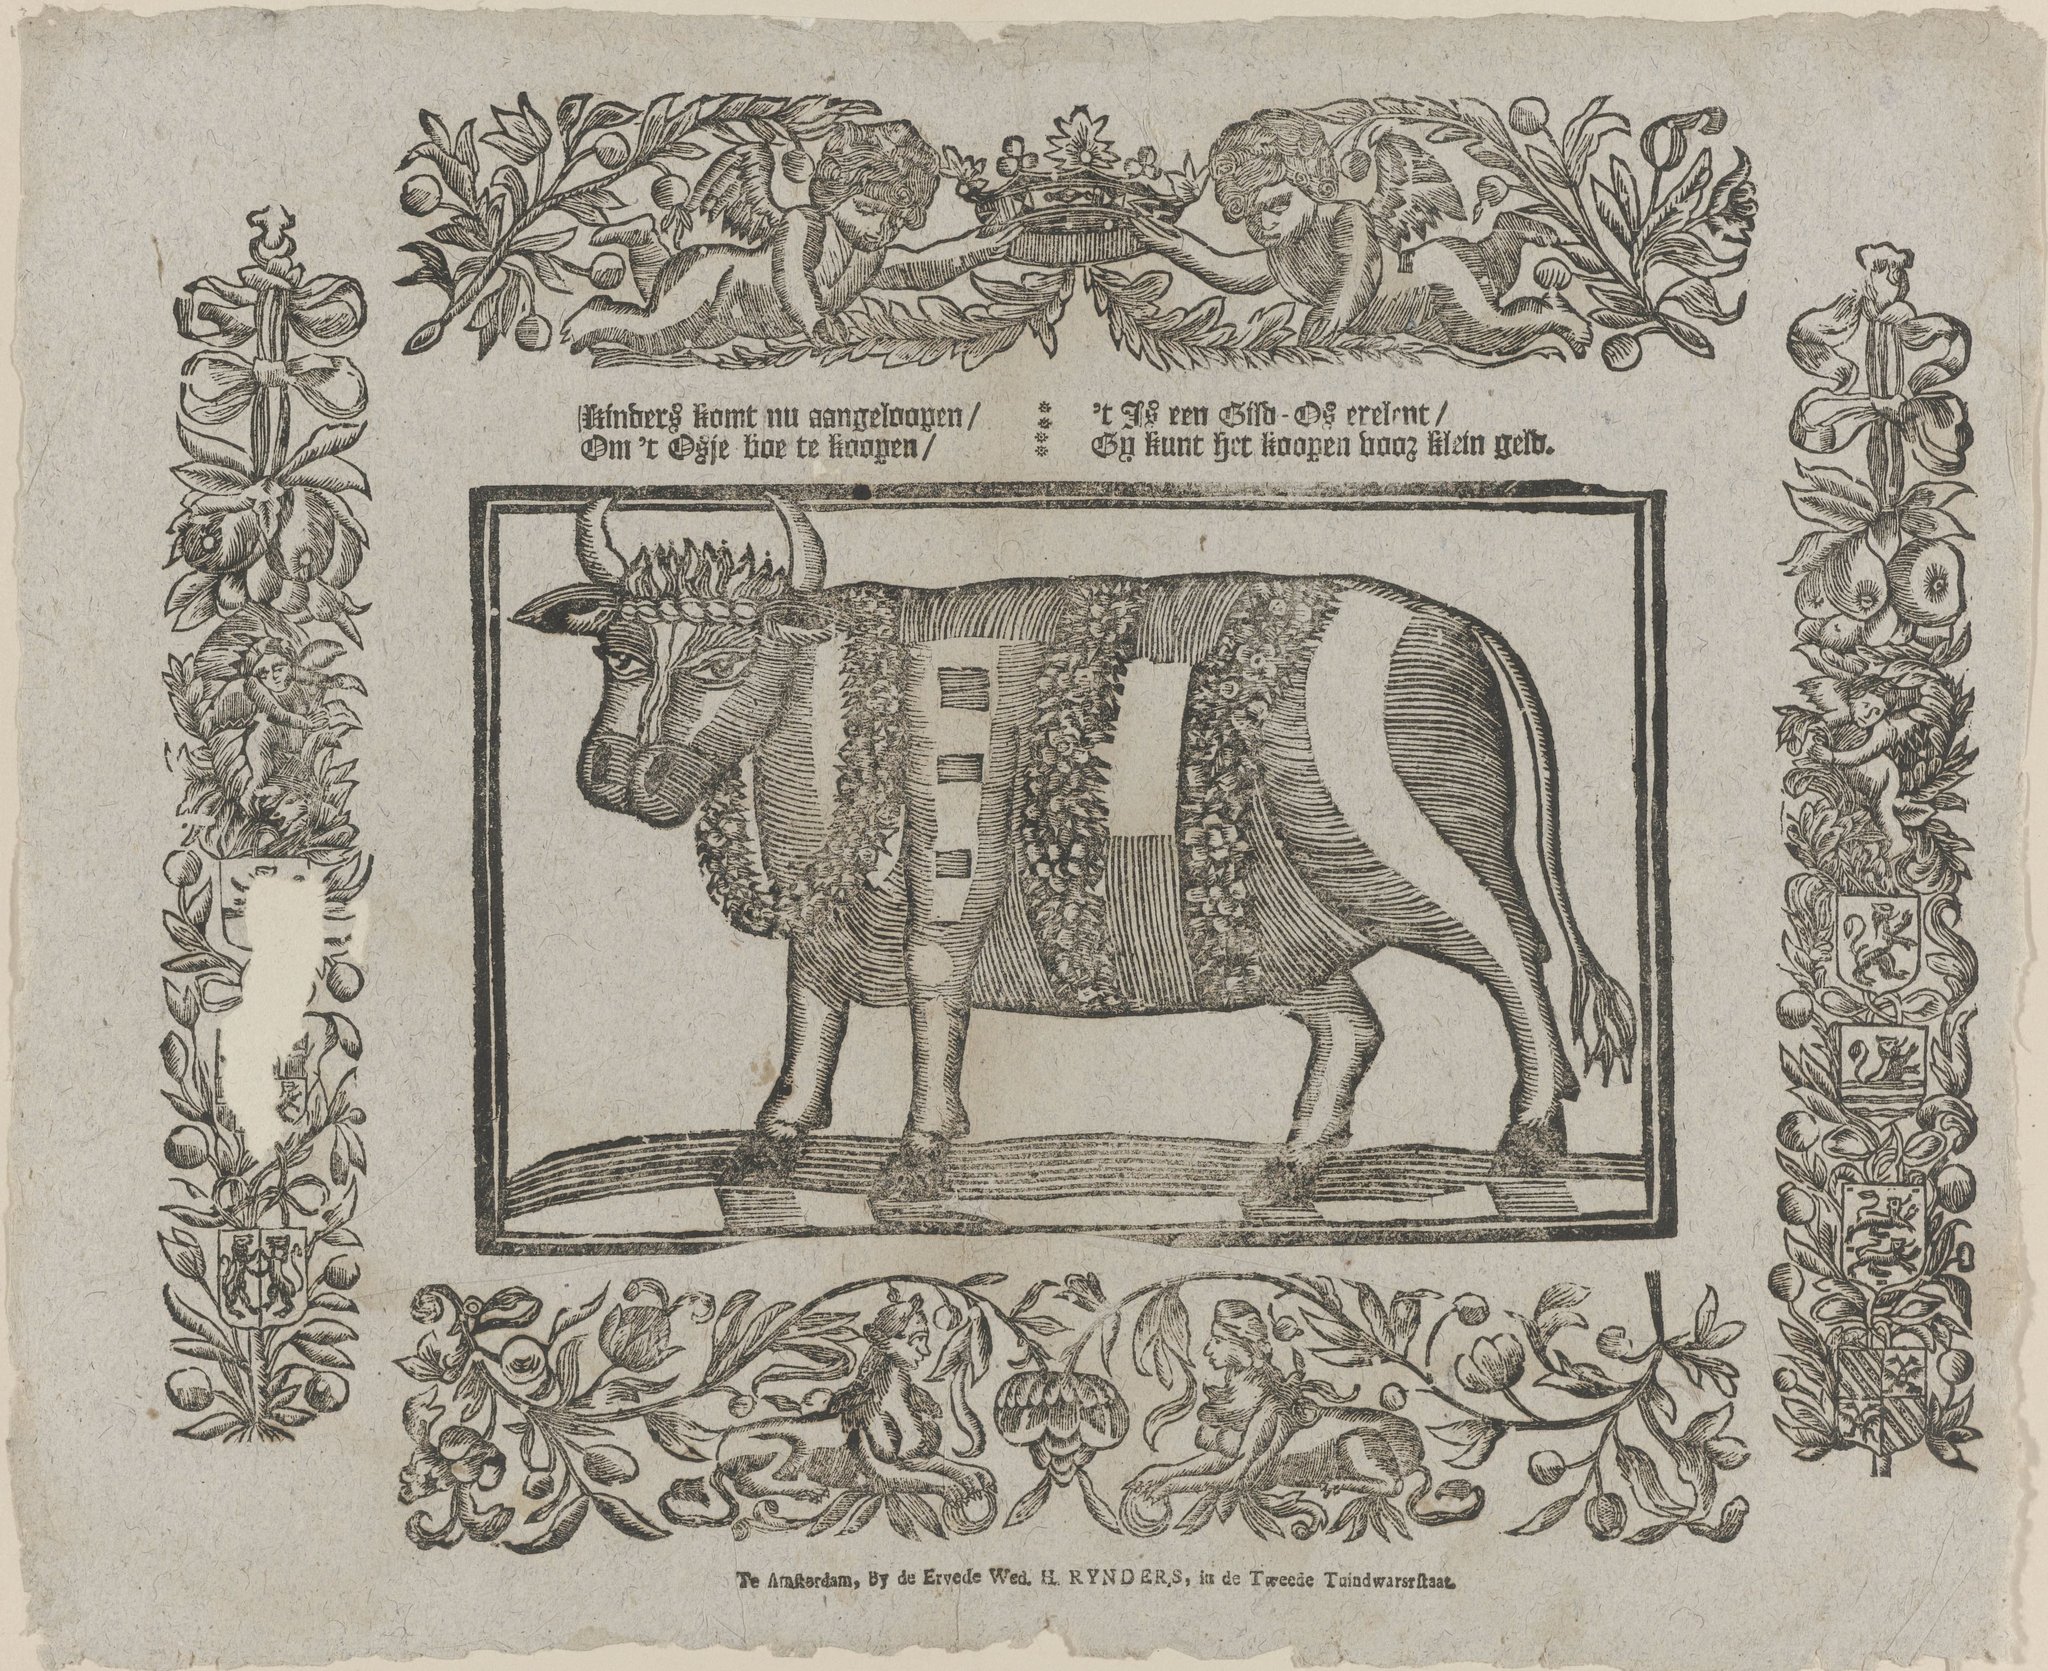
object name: print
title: Kinders komt nu aangeloopen / Om 't osje boe te koopen / 't is een gild-os exelent / Gy kunt het koopen voor klein geld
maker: Anonymous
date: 1781-1831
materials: paper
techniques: letterpress printing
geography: netherlands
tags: floral interlace ~ ornament, prize-ox, ox, cupids: 'amores', 'amoretti', 'putti'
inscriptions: collector's mark: Lugt 2760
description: Blad met een grote voorstelling van een gilde-os (ook kermisos of prijsos genoemd), versierd met bloemenkransen. De voorstelling is gevat in een sierlijst met ranken, sfinxen, wapenschilden, putti en bloemen.